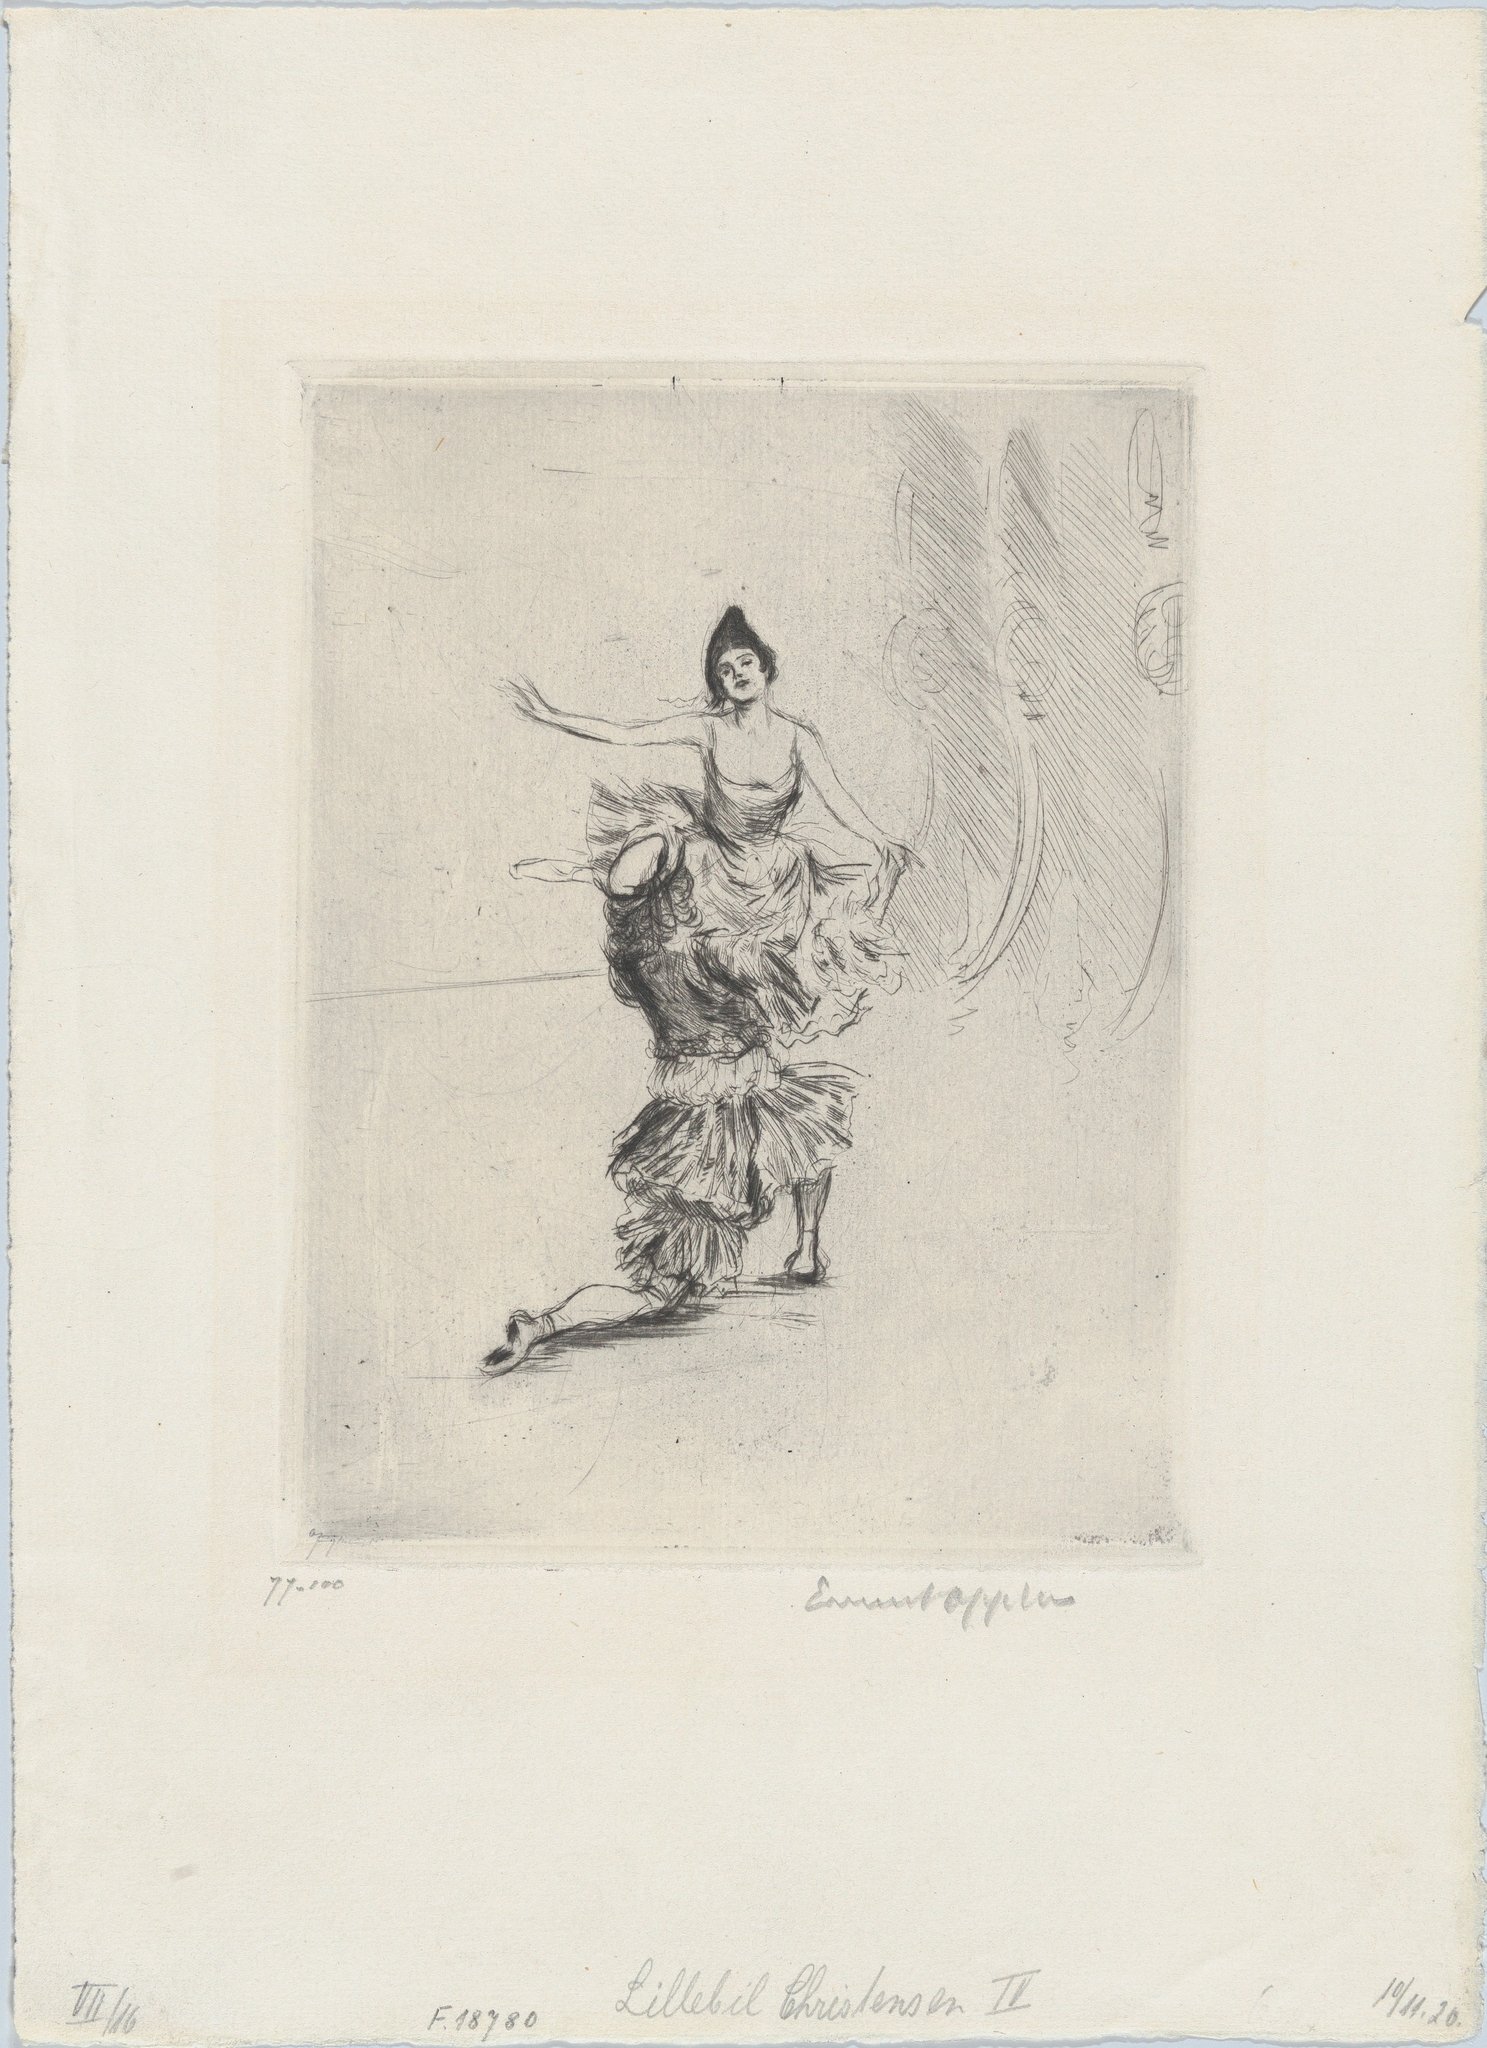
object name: print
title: Lillebil Christensen IV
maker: ernst oppler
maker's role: artist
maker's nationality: german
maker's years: 1867-1929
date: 1920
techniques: etching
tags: women,dancing